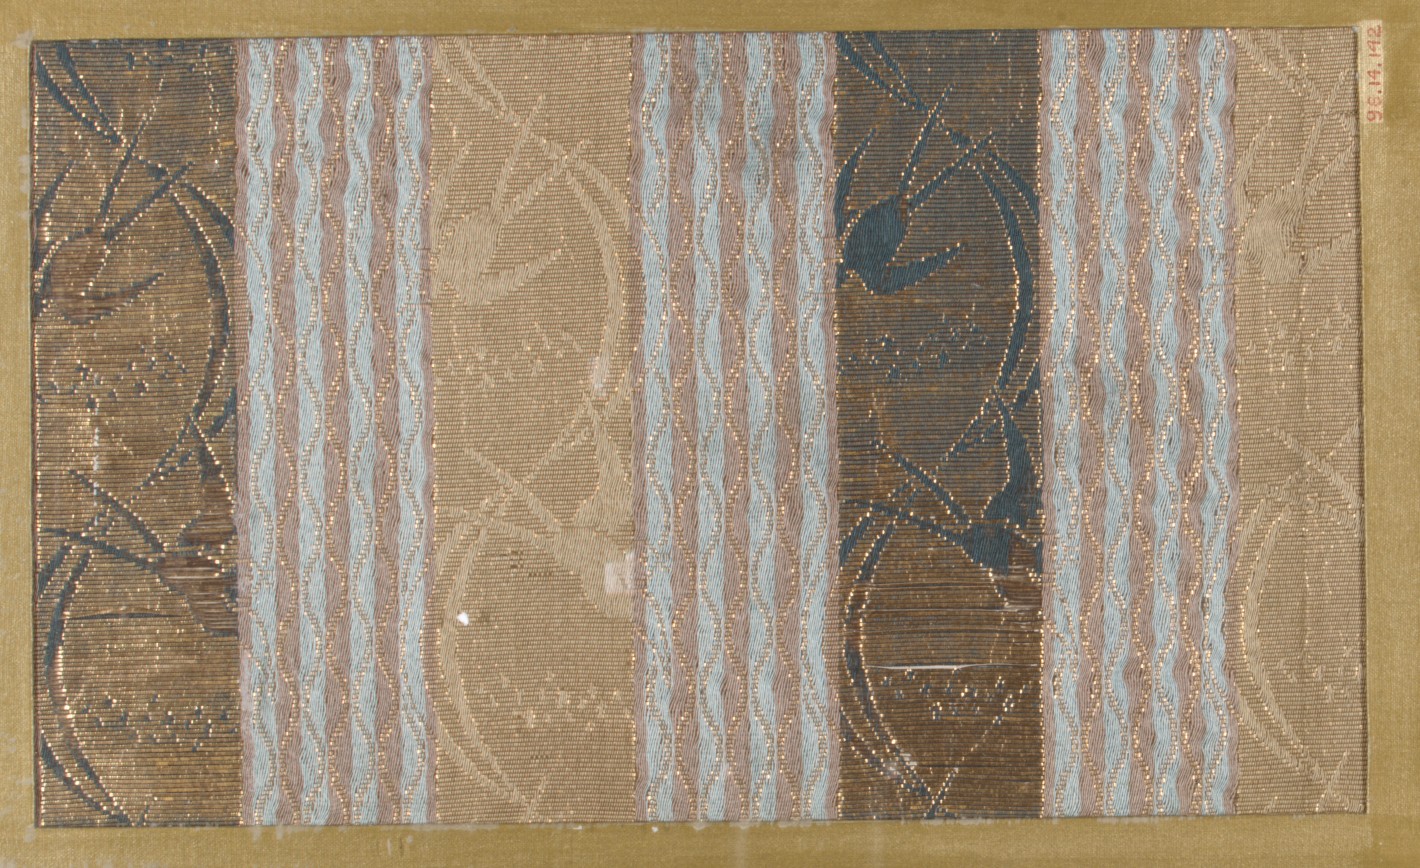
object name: piece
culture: japanese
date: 1801-1900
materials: silk